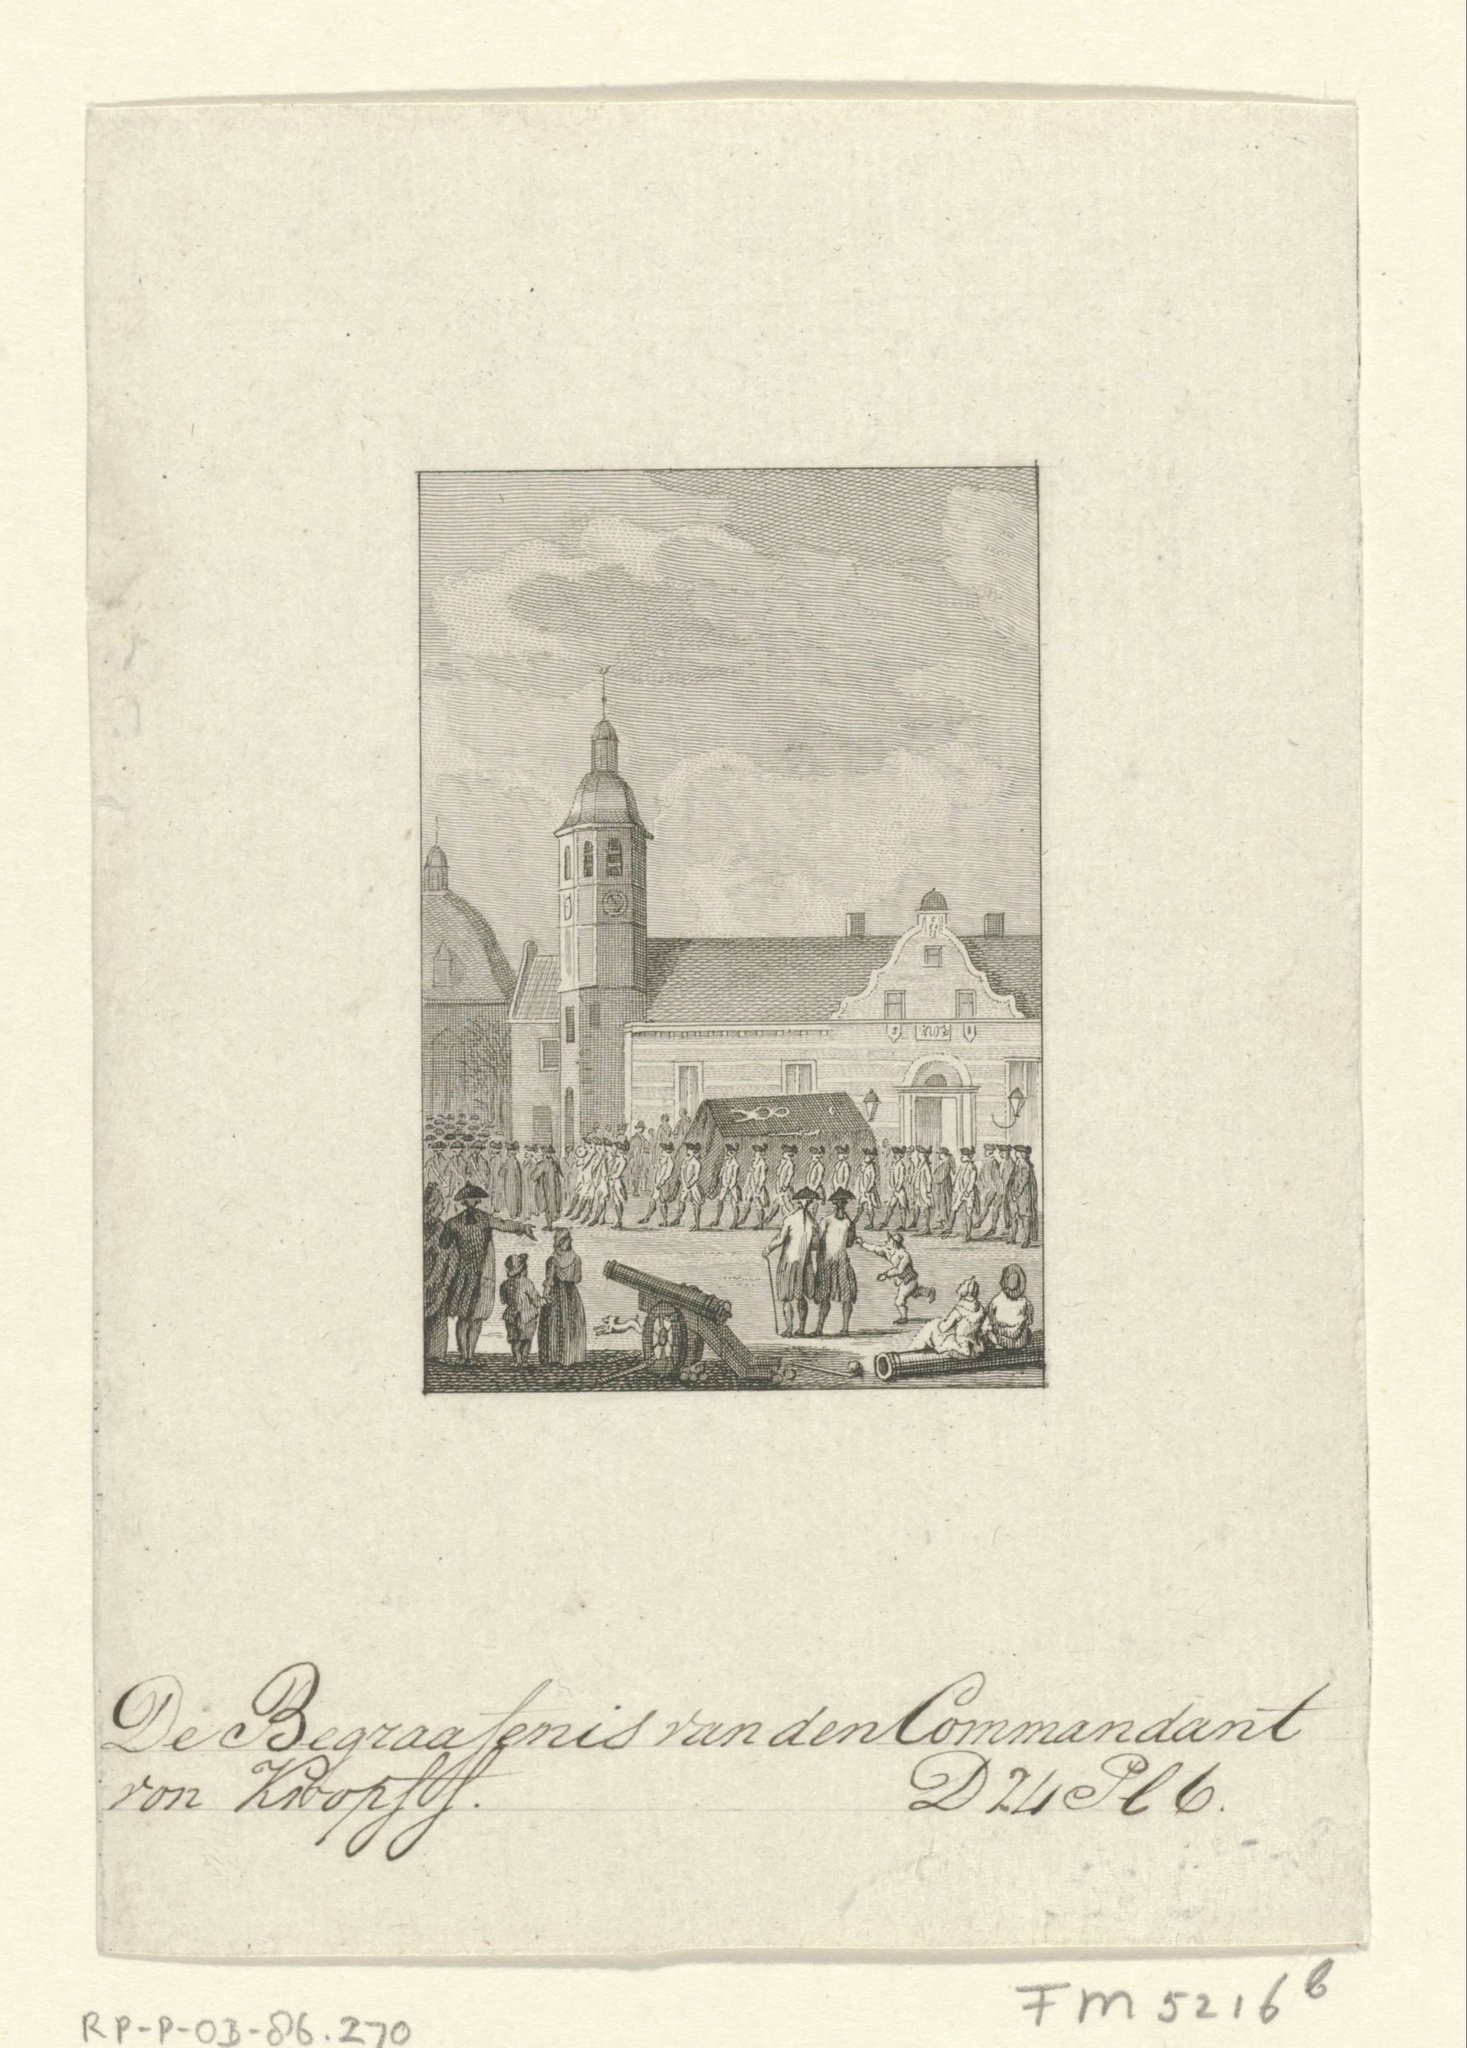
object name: print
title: Begrafenisstoet voor Joachim Maurits baron van Kropff, 1793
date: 1793-1795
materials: paper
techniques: etching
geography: northern netherlands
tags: public funeral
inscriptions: collector's mark: Lugt 2228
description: Gebruikt als illustratie in: J. Fokke, Geschiedenissen der Vereenigde Nederlanden voor de vaderlandsche jeugd, Johannes Allart, Amsterdam 1783-1795, 25 delen, dl. 24, pl. 6. Gebaseerd op de prent van Bogerts naar Hausdorff en Bulthuis, zie FMH 5215.